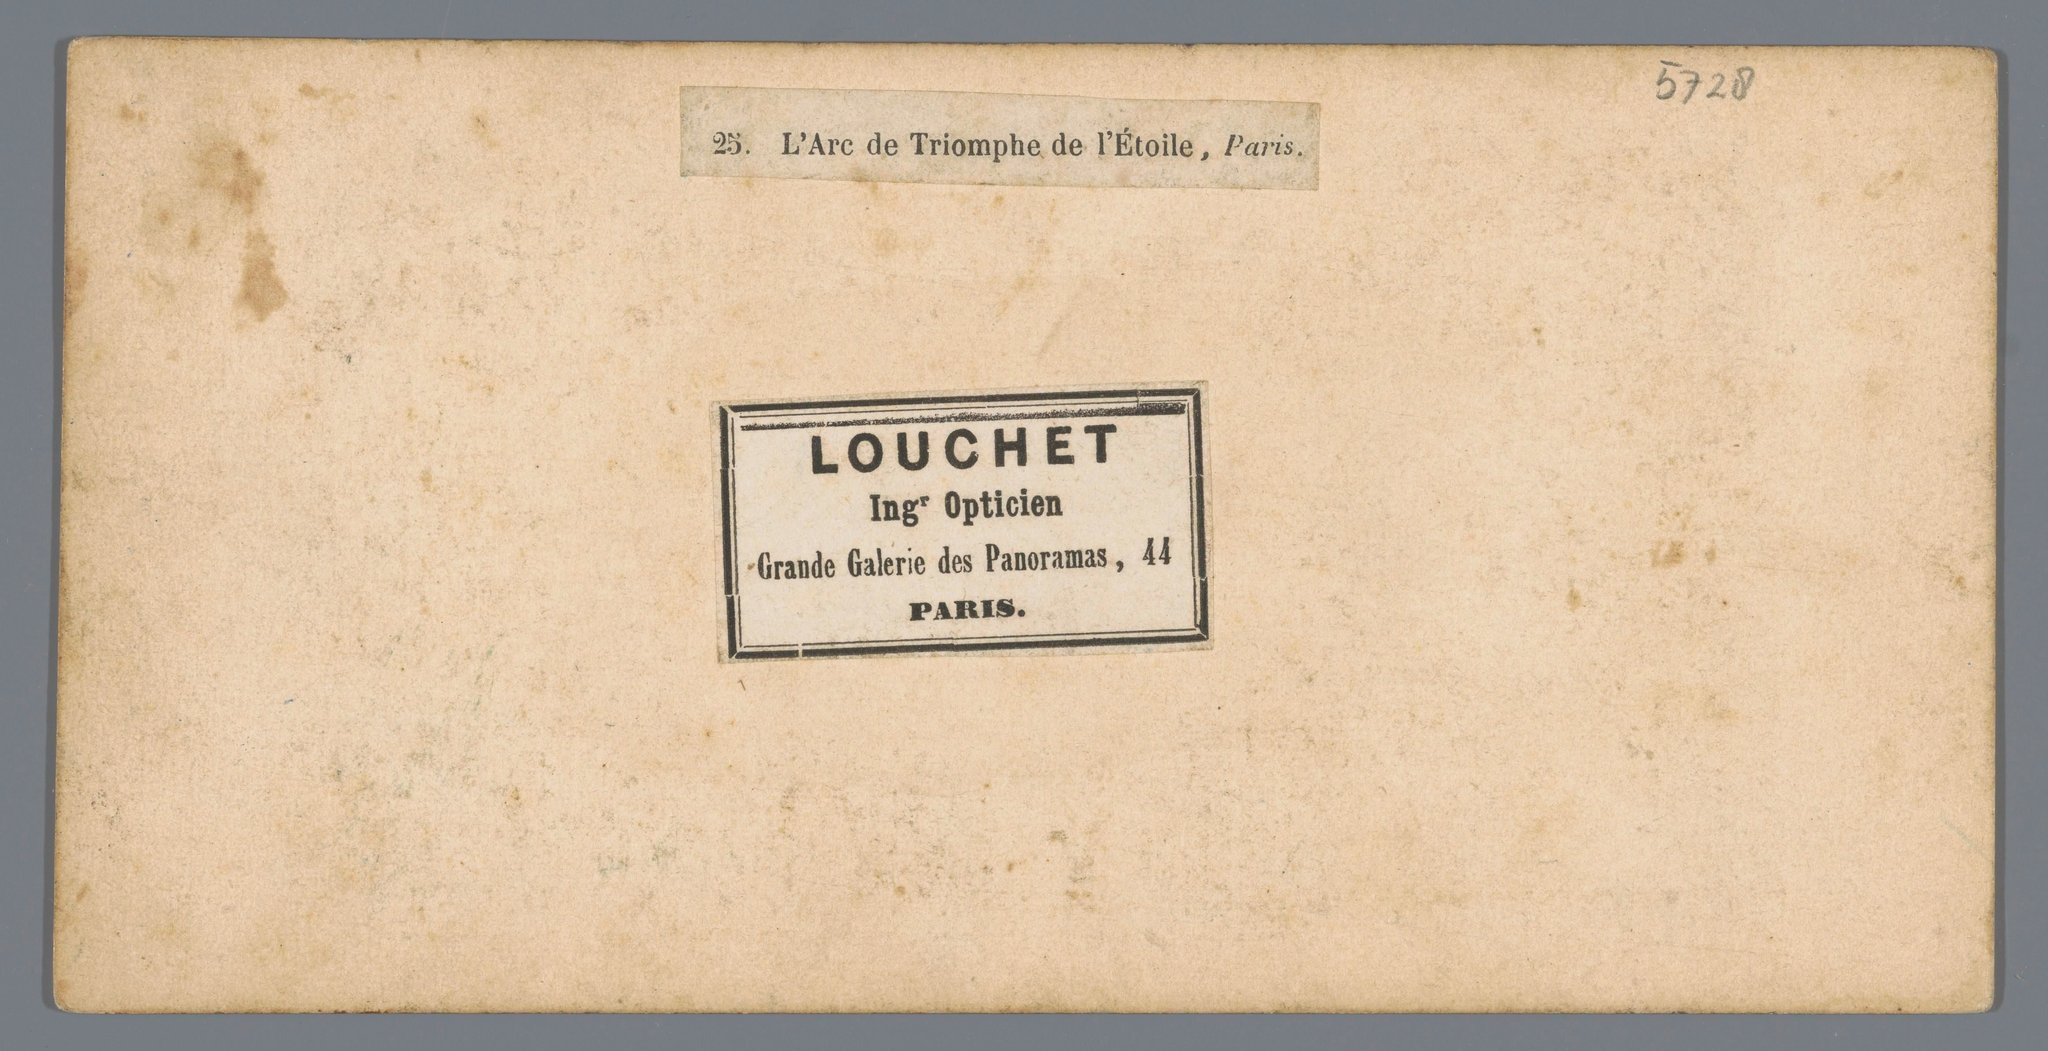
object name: stereograph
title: Reliëf op de Arc de Triomphe in Parijs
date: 1850-1880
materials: cardboard, photographic support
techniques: albumen print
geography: paris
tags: triumphal arch, decorating 'en relief', appliquéing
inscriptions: name: ‘Louchet Ingr Opticien Grande Galerie des Panoramas, 44 Paris.’, monogram: ‘V.F.’, number: ‘25’